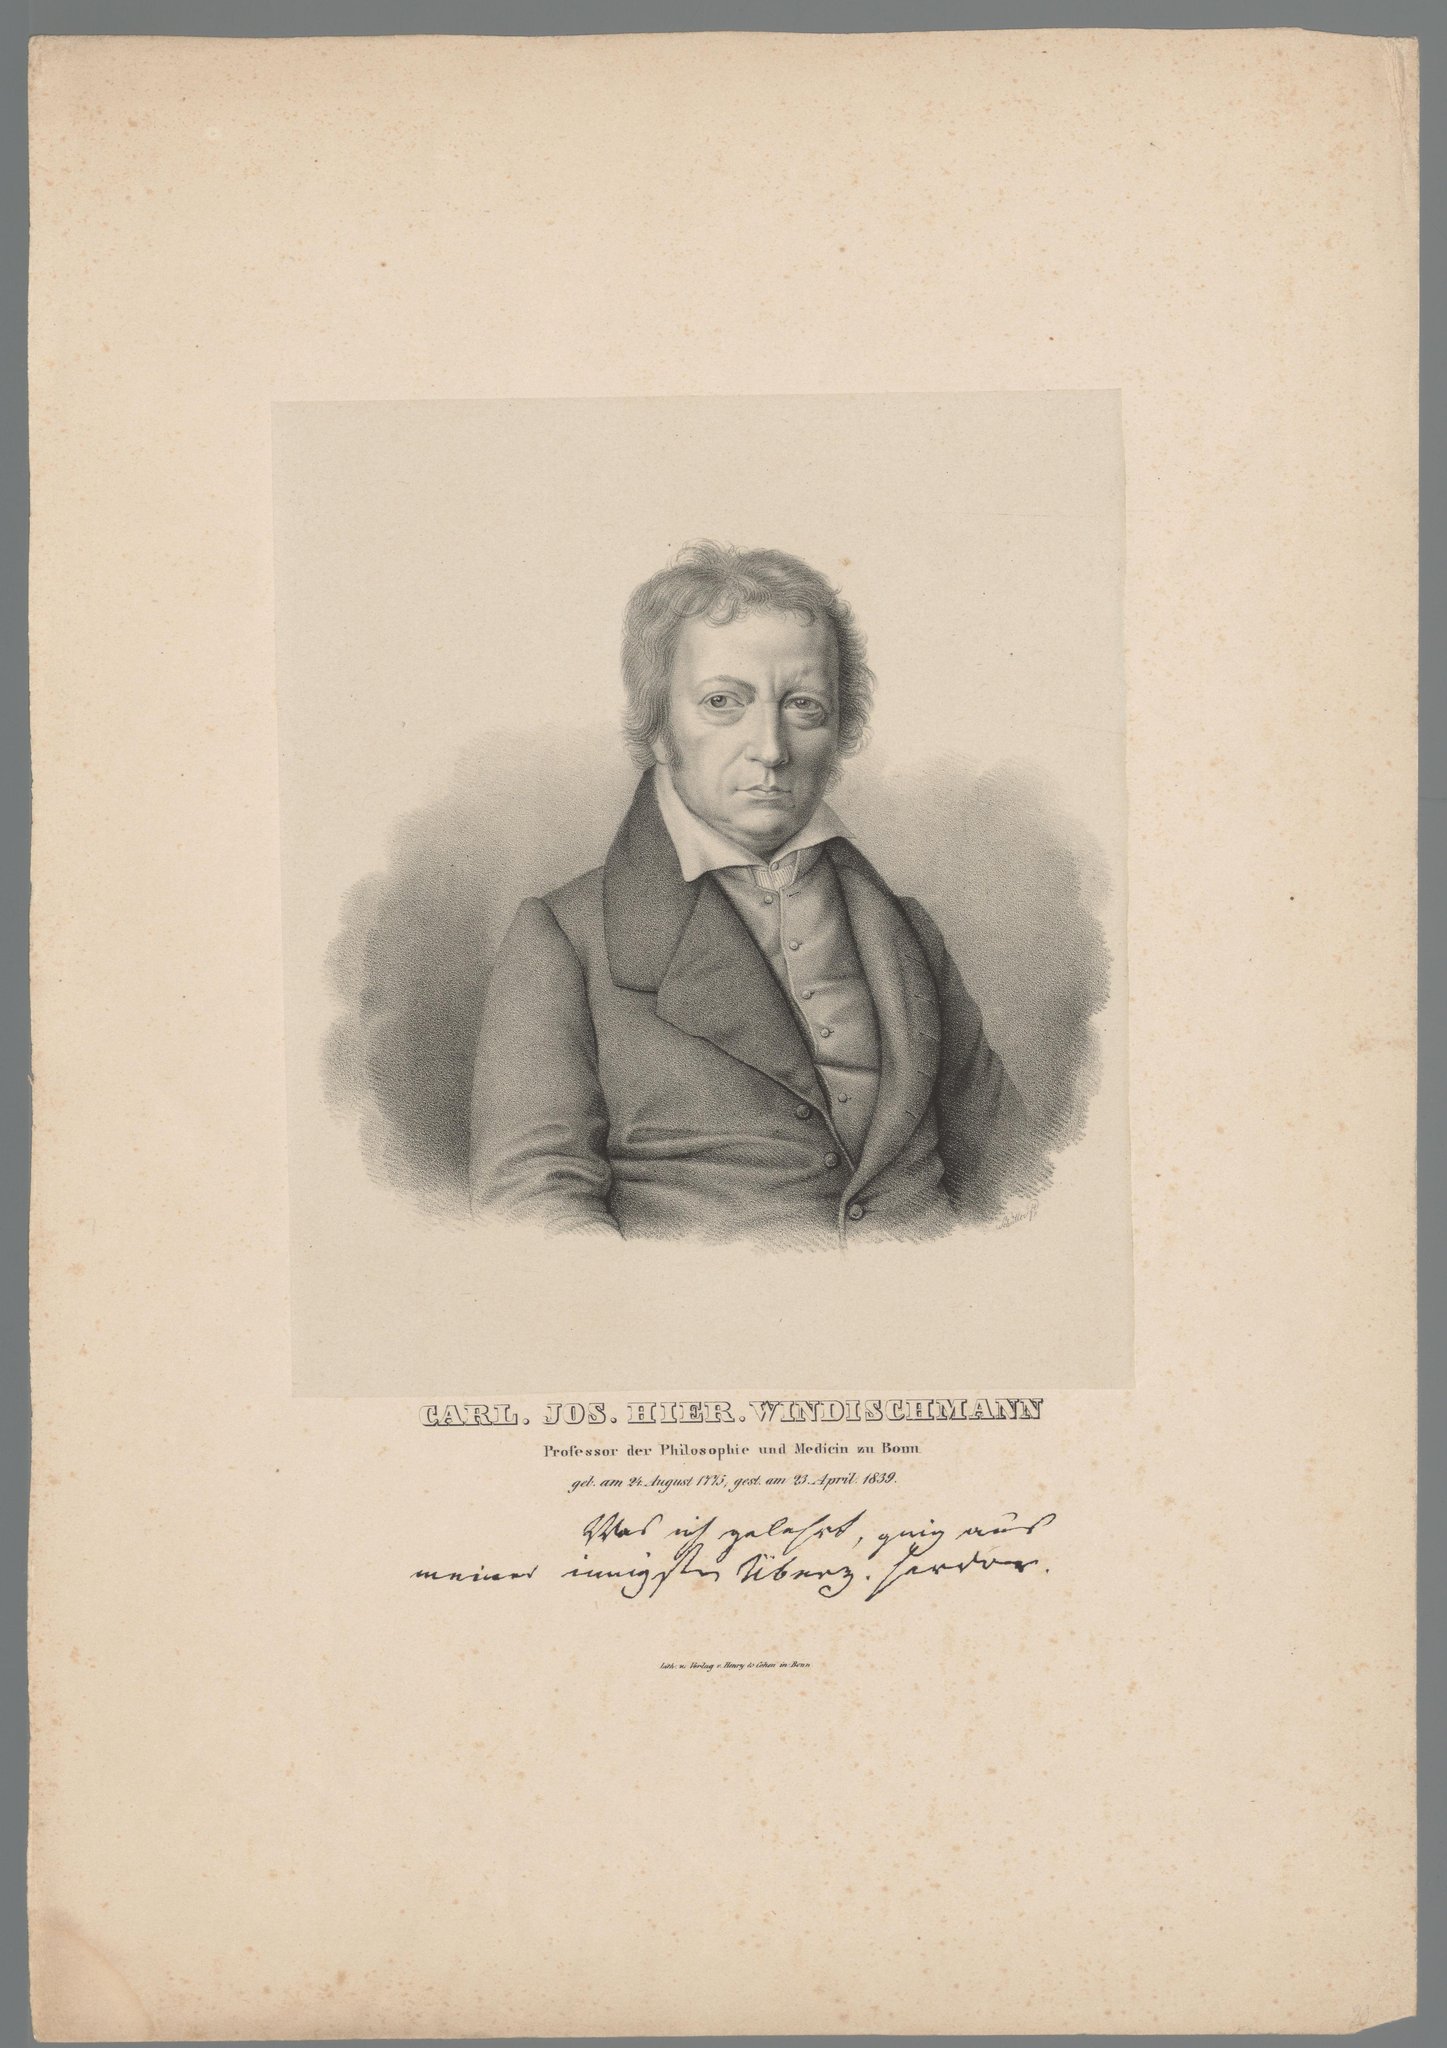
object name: print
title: Portret van Karl Joseph Hieronymus Windischmann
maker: schütter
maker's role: print maker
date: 1830-1880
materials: paper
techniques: lithograph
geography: bonn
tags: historical persons, scholar, philosopher (+ portrait of scholar, scientist)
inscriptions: collector's mark: Lugt 2228